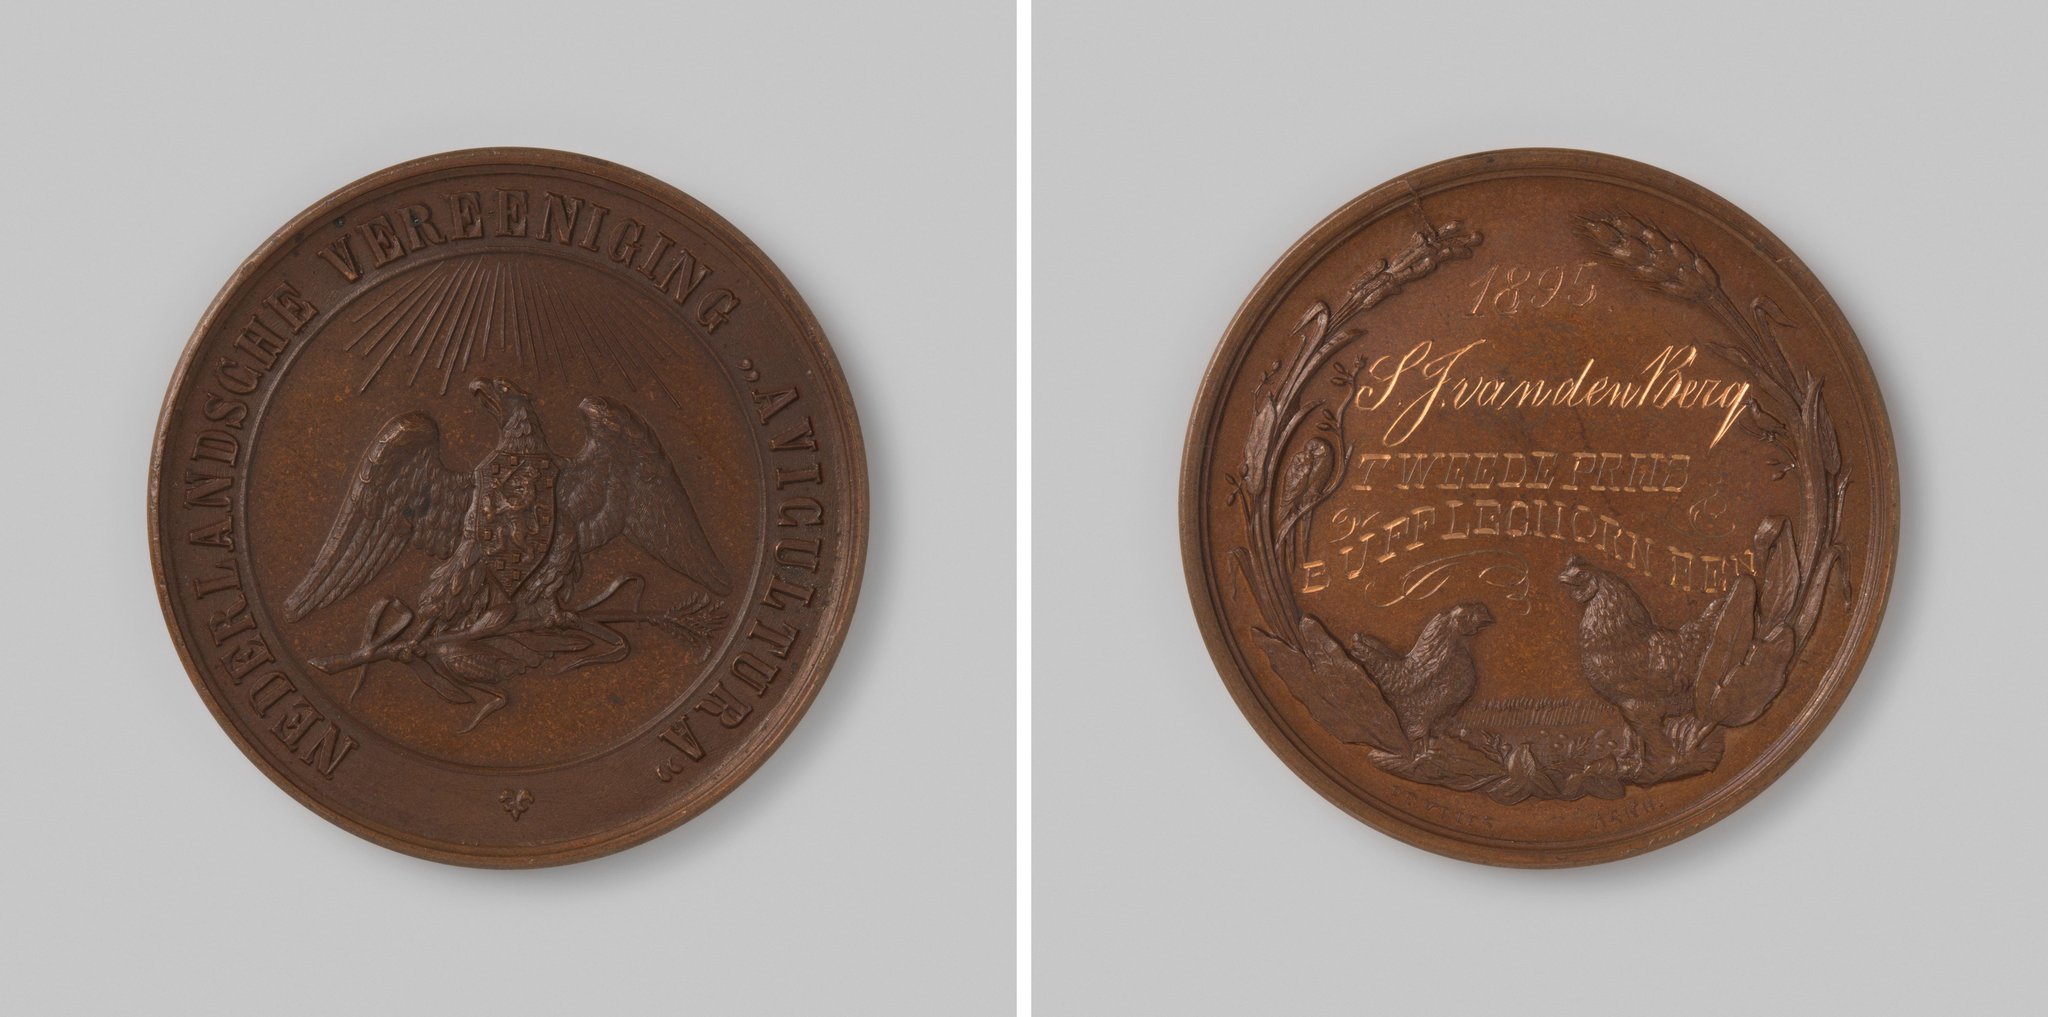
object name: medal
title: Prijspenning van de Nederlandsche Vereeniging Aviculture 1895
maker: alexander isaac de vries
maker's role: graveur, koopman, medailleur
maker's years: 1820-1901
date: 1887-1895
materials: bronze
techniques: striking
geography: arnhem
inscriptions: inscription: ‘1895 / S.J. van den Berg / TWEEDE PRIJS / BUFF LEGHORN HEN’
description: Bronzen penning, op de voorzijde een adelaar, met borstschild Nederland, met gespreide vleugels zittend op een maistak onder een stralende hemel, met omschrift, op de keerzijde een inscriptieruimte tussen takken van diverse planten, waartussen een uil, een kip en een haan.